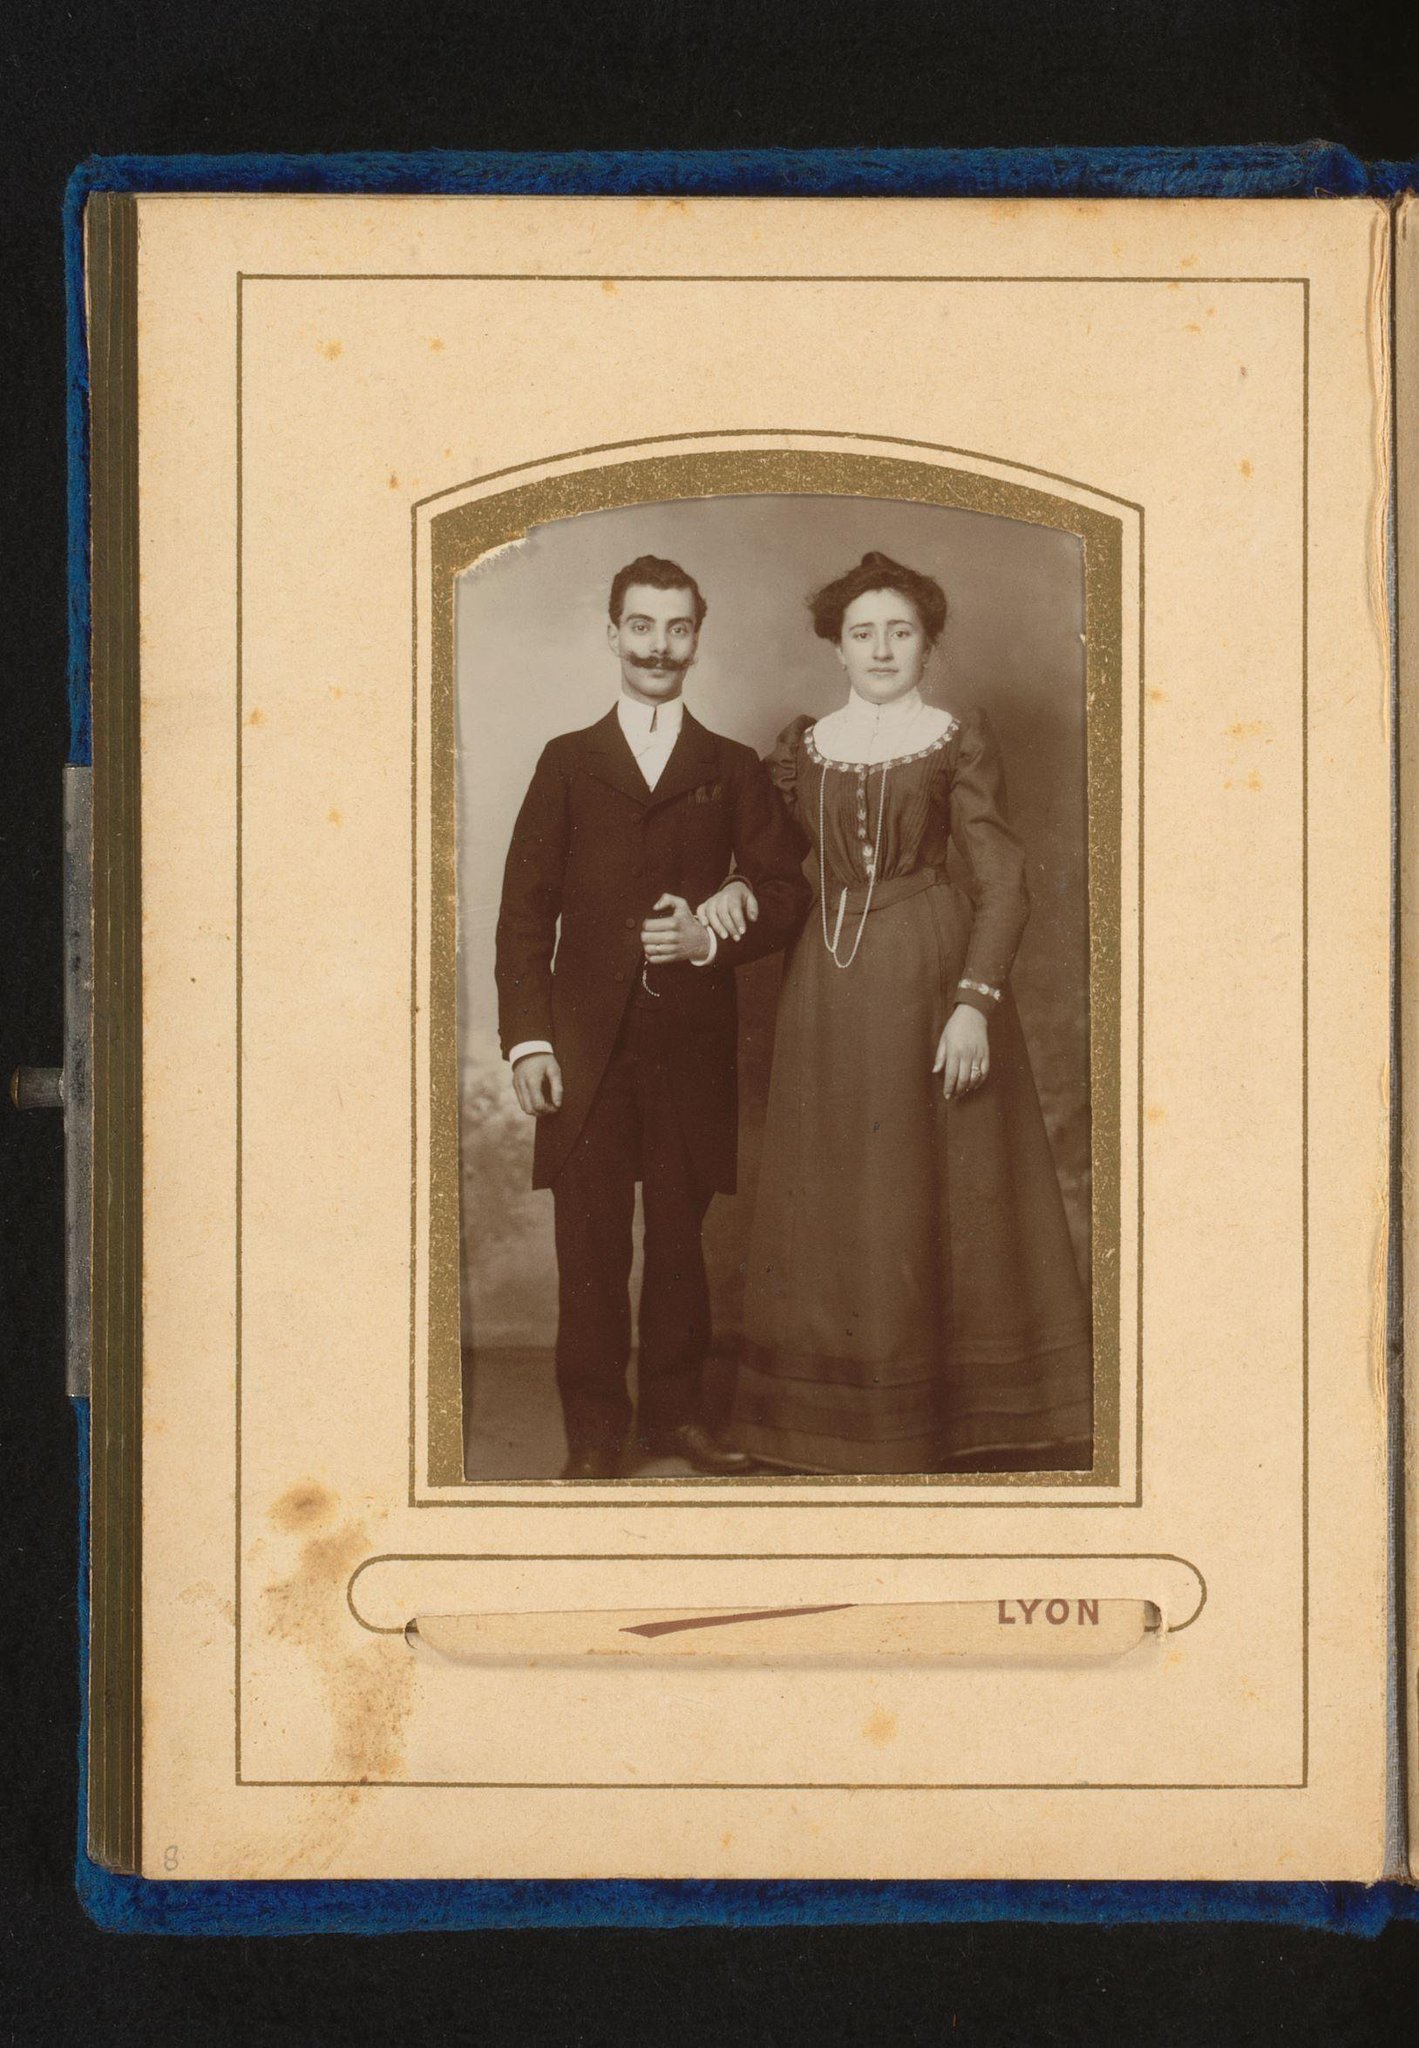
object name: photograph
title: Portret van een echtpaar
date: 1894-1920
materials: cardboard, photographic support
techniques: collodion silver print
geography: lyon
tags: historical persons - bb - woman, historical persons, marriage, married couple, 'matrimonium'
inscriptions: inscription: ‘Médaille à l'Expon Universelle/ LYON 1894./ Photographie/ Artistique/ Gaude Frères/ 176, Rue Garibaldi, 176/ Lyon/ Les Clichés sont conservés’